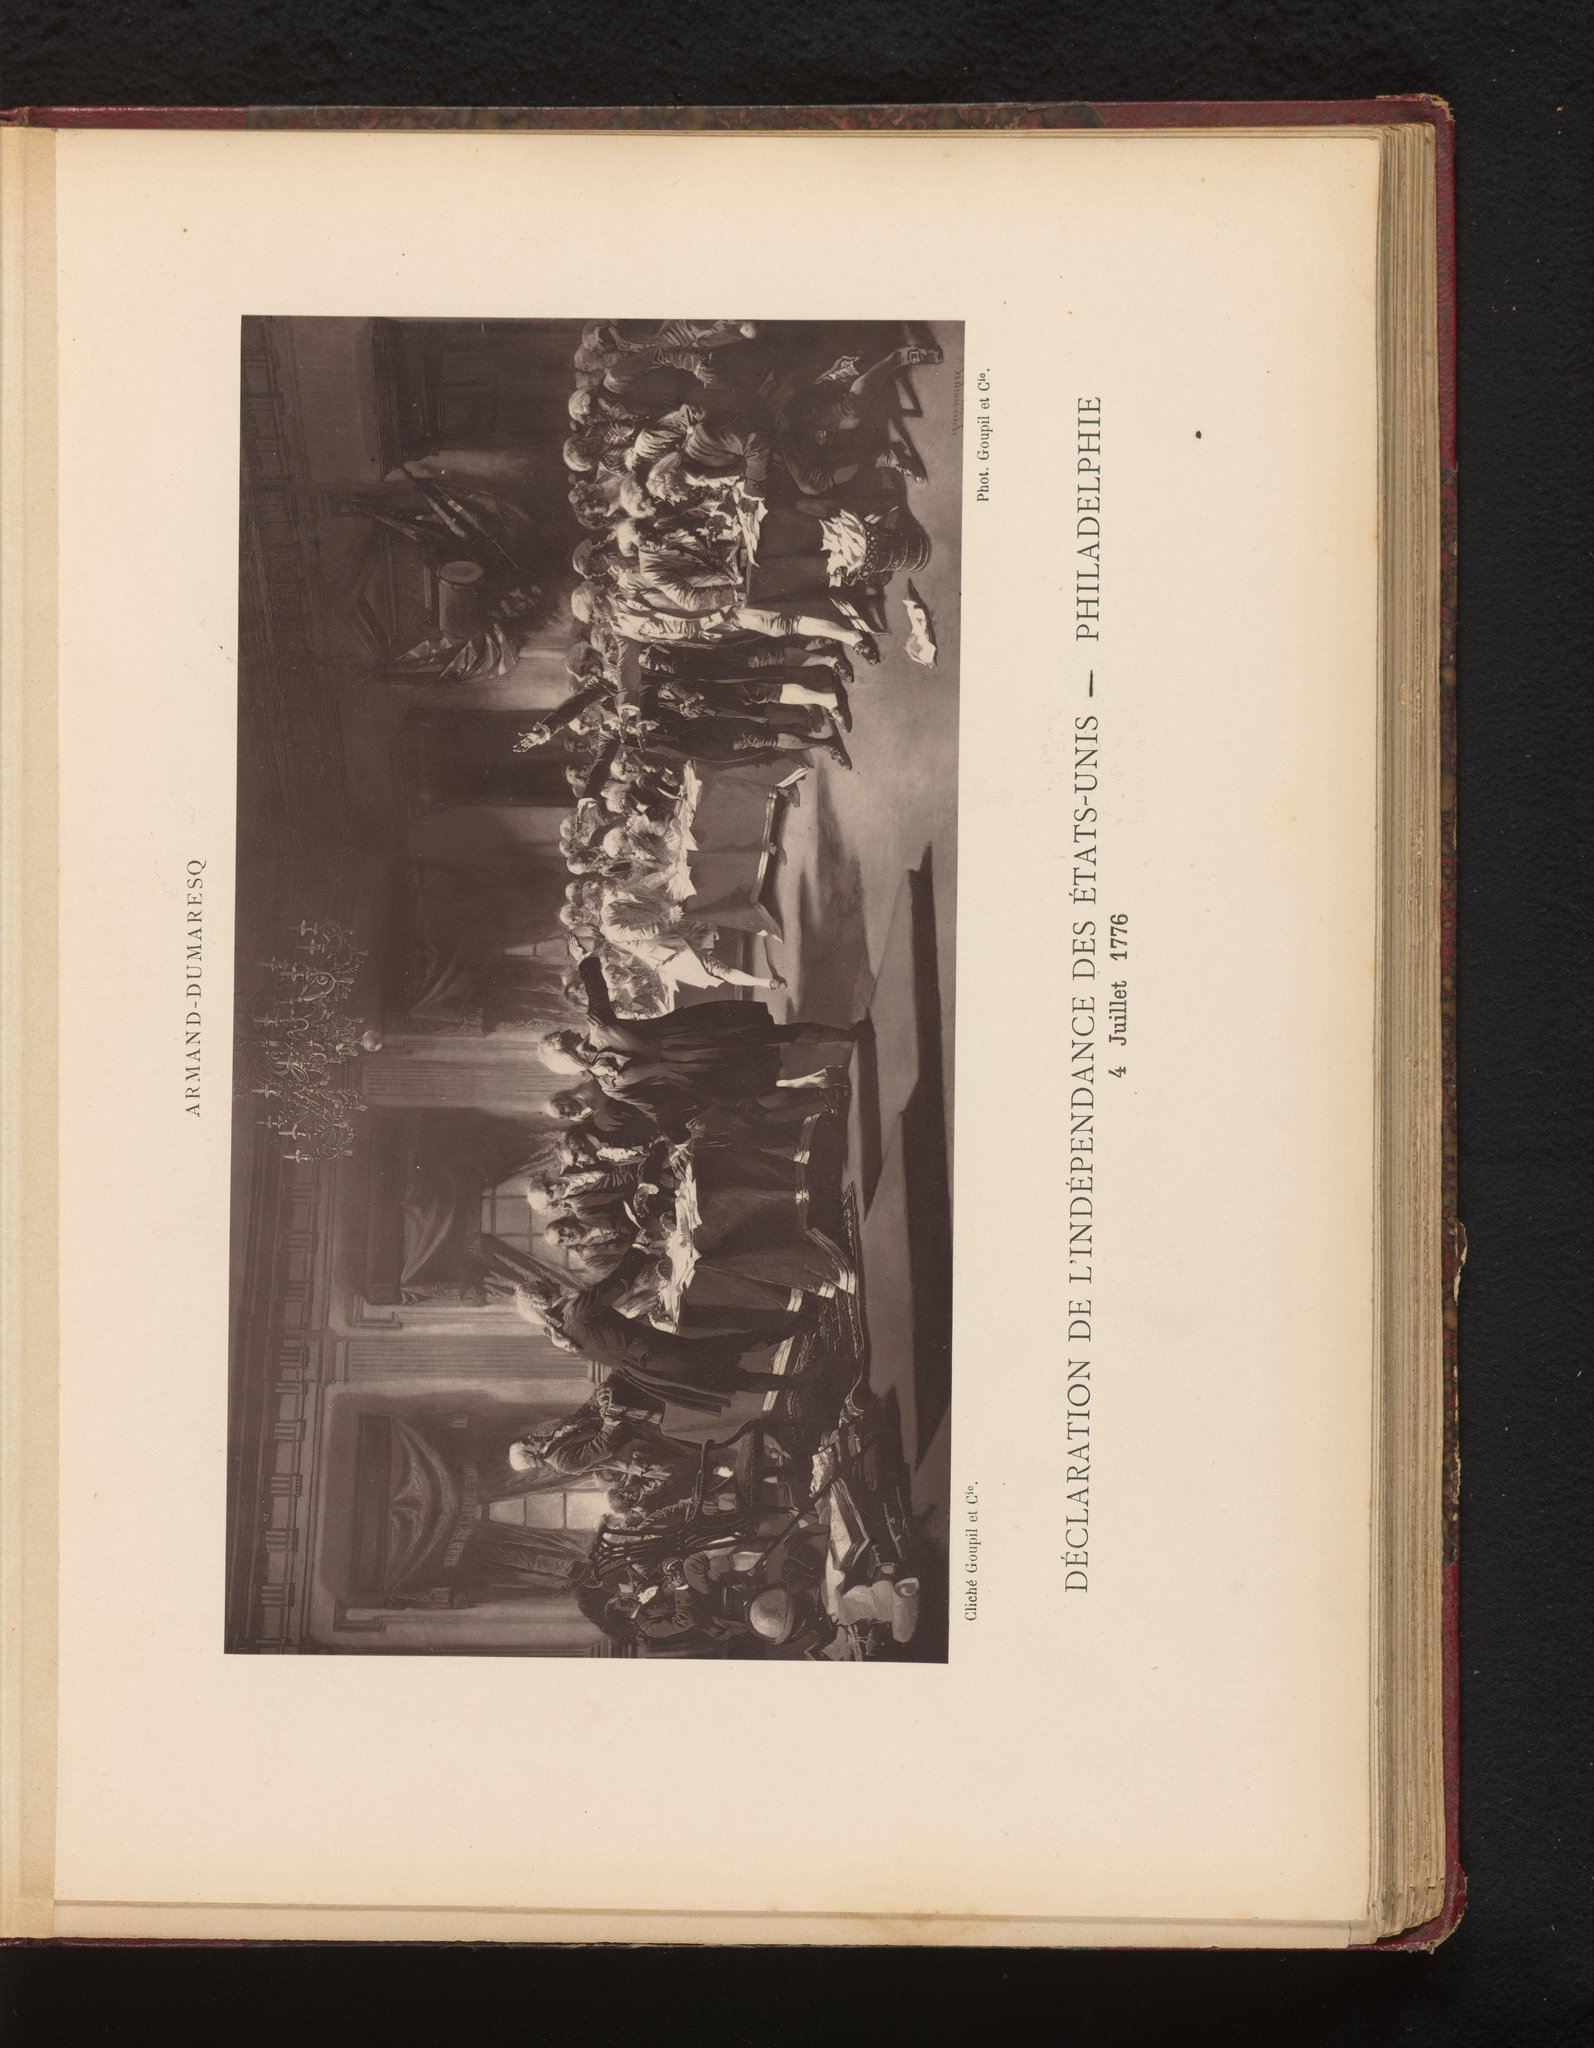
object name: photomechanical print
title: Fotoreproductie van het schilderij 'Declaration de l'Indépendance des États-Unis - Philadelphie, 4 Juillet 1776' door Charles Édouard Armand-Dumaresq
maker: edouard armand-dumaresq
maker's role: painter, print maker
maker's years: 1826-1895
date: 1876-1881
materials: paper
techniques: woodburytype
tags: politics, independence day